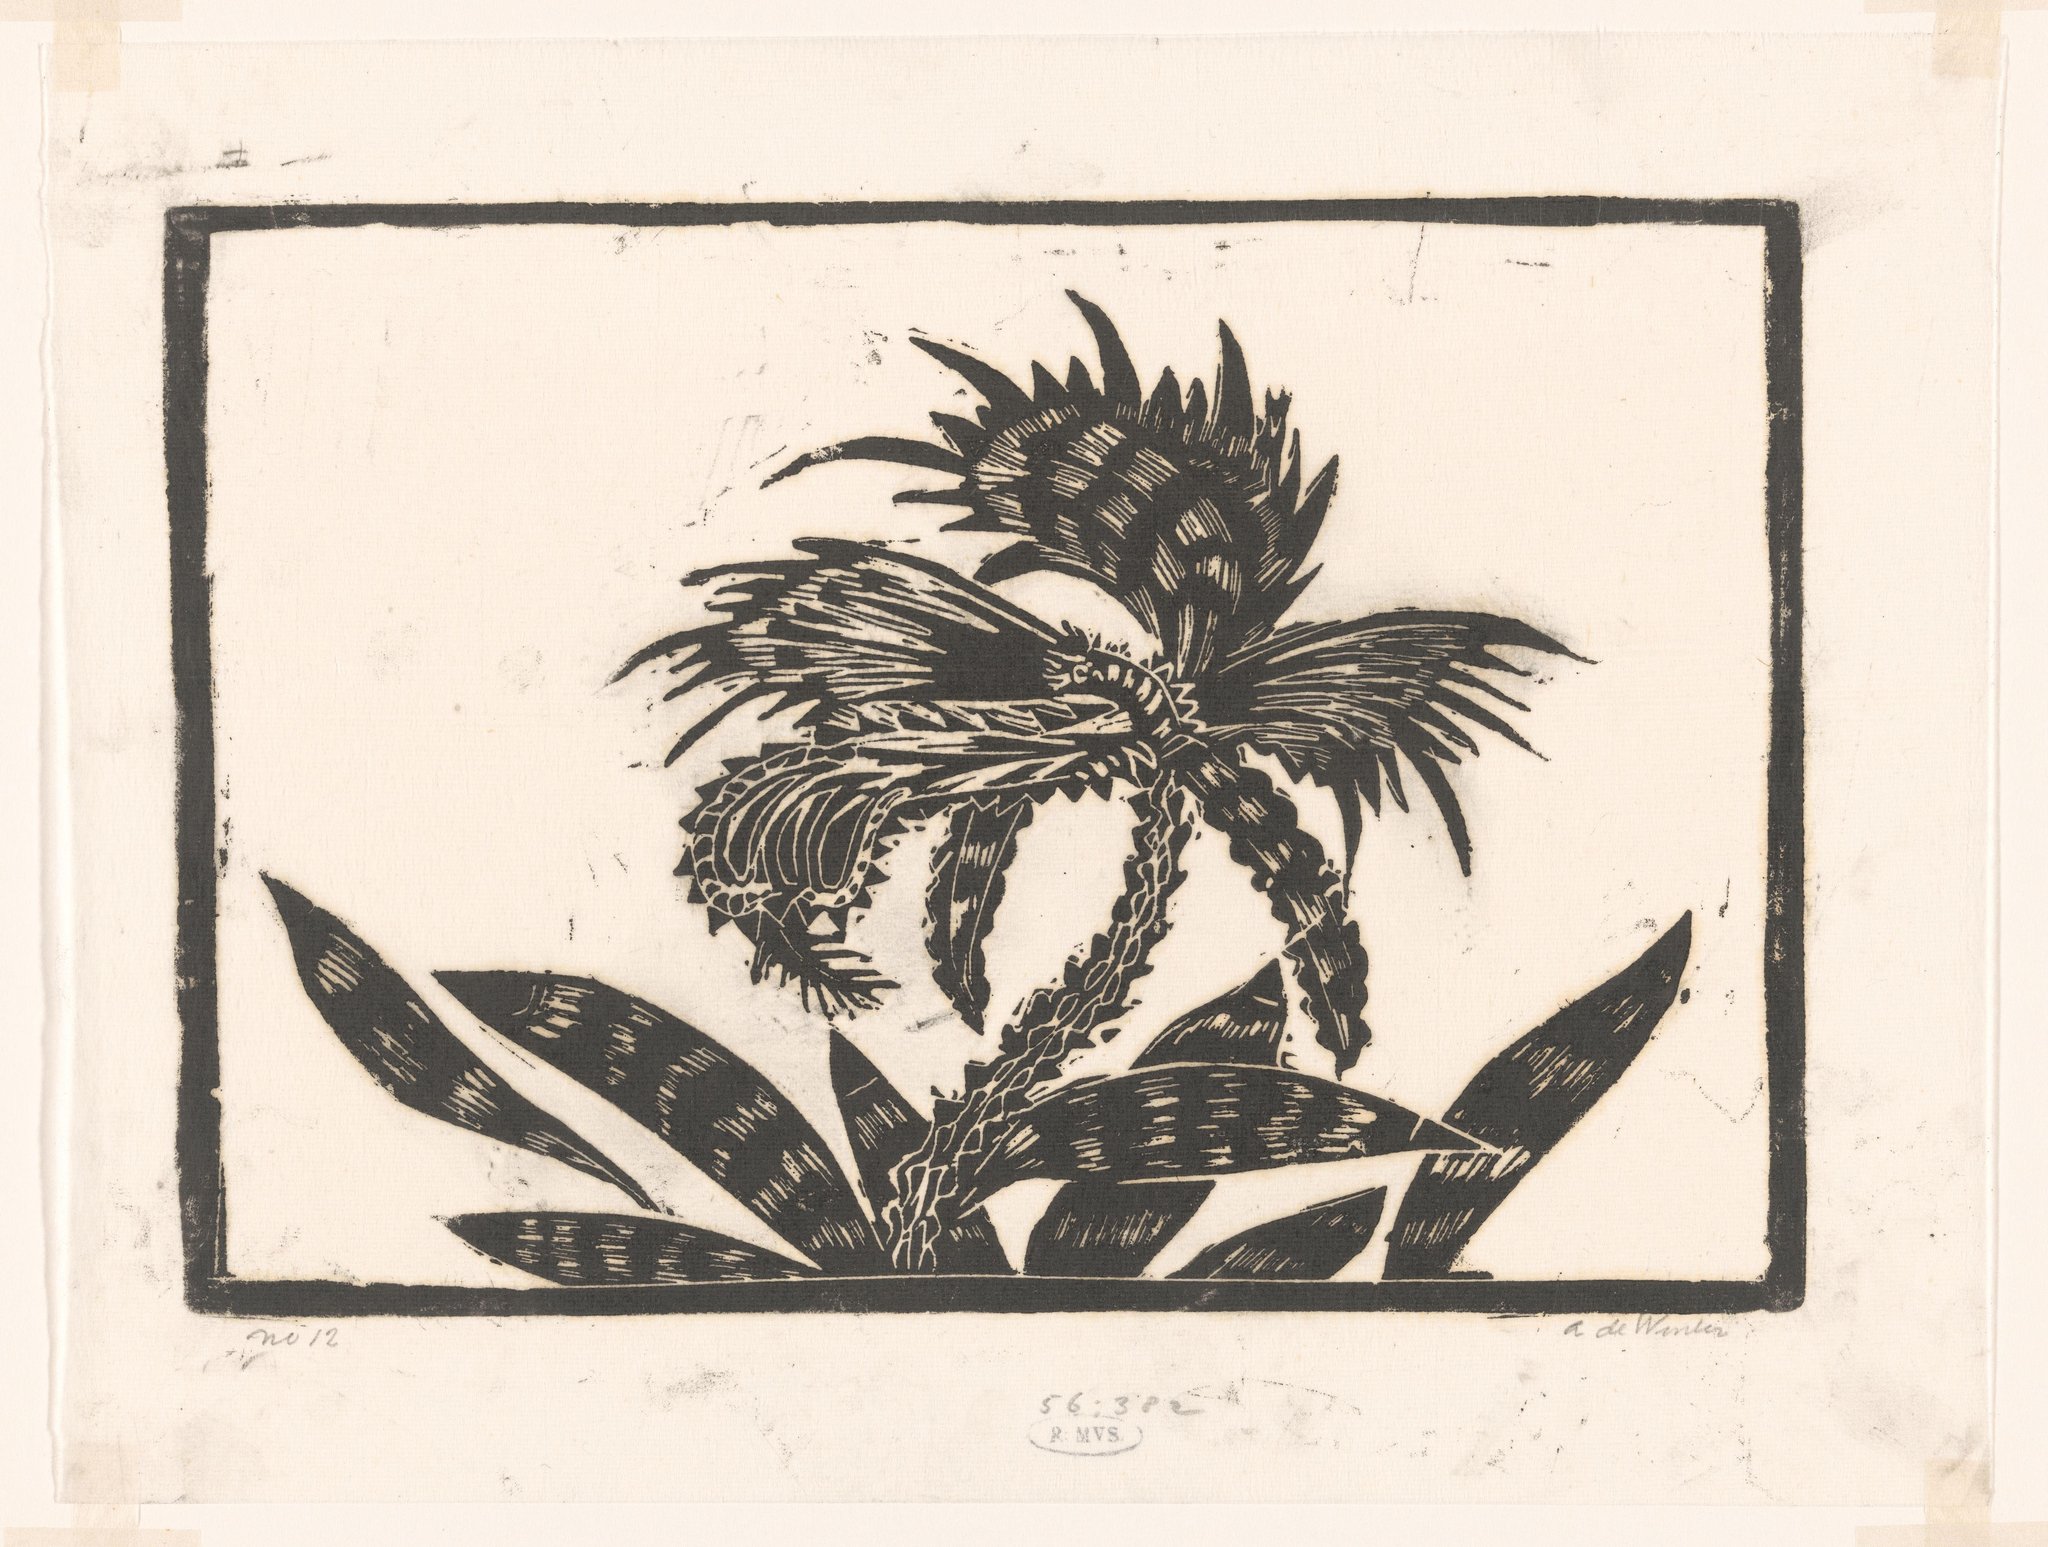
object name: print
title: Plant met bloem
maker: janus de winter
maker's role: print maker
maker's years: 1882-1951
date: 1892-1951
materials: paper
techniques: linocut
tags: flowers, plants and herbs: cactus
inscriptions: inscription: ‘No 12’, collector's mark: Lugt 2228